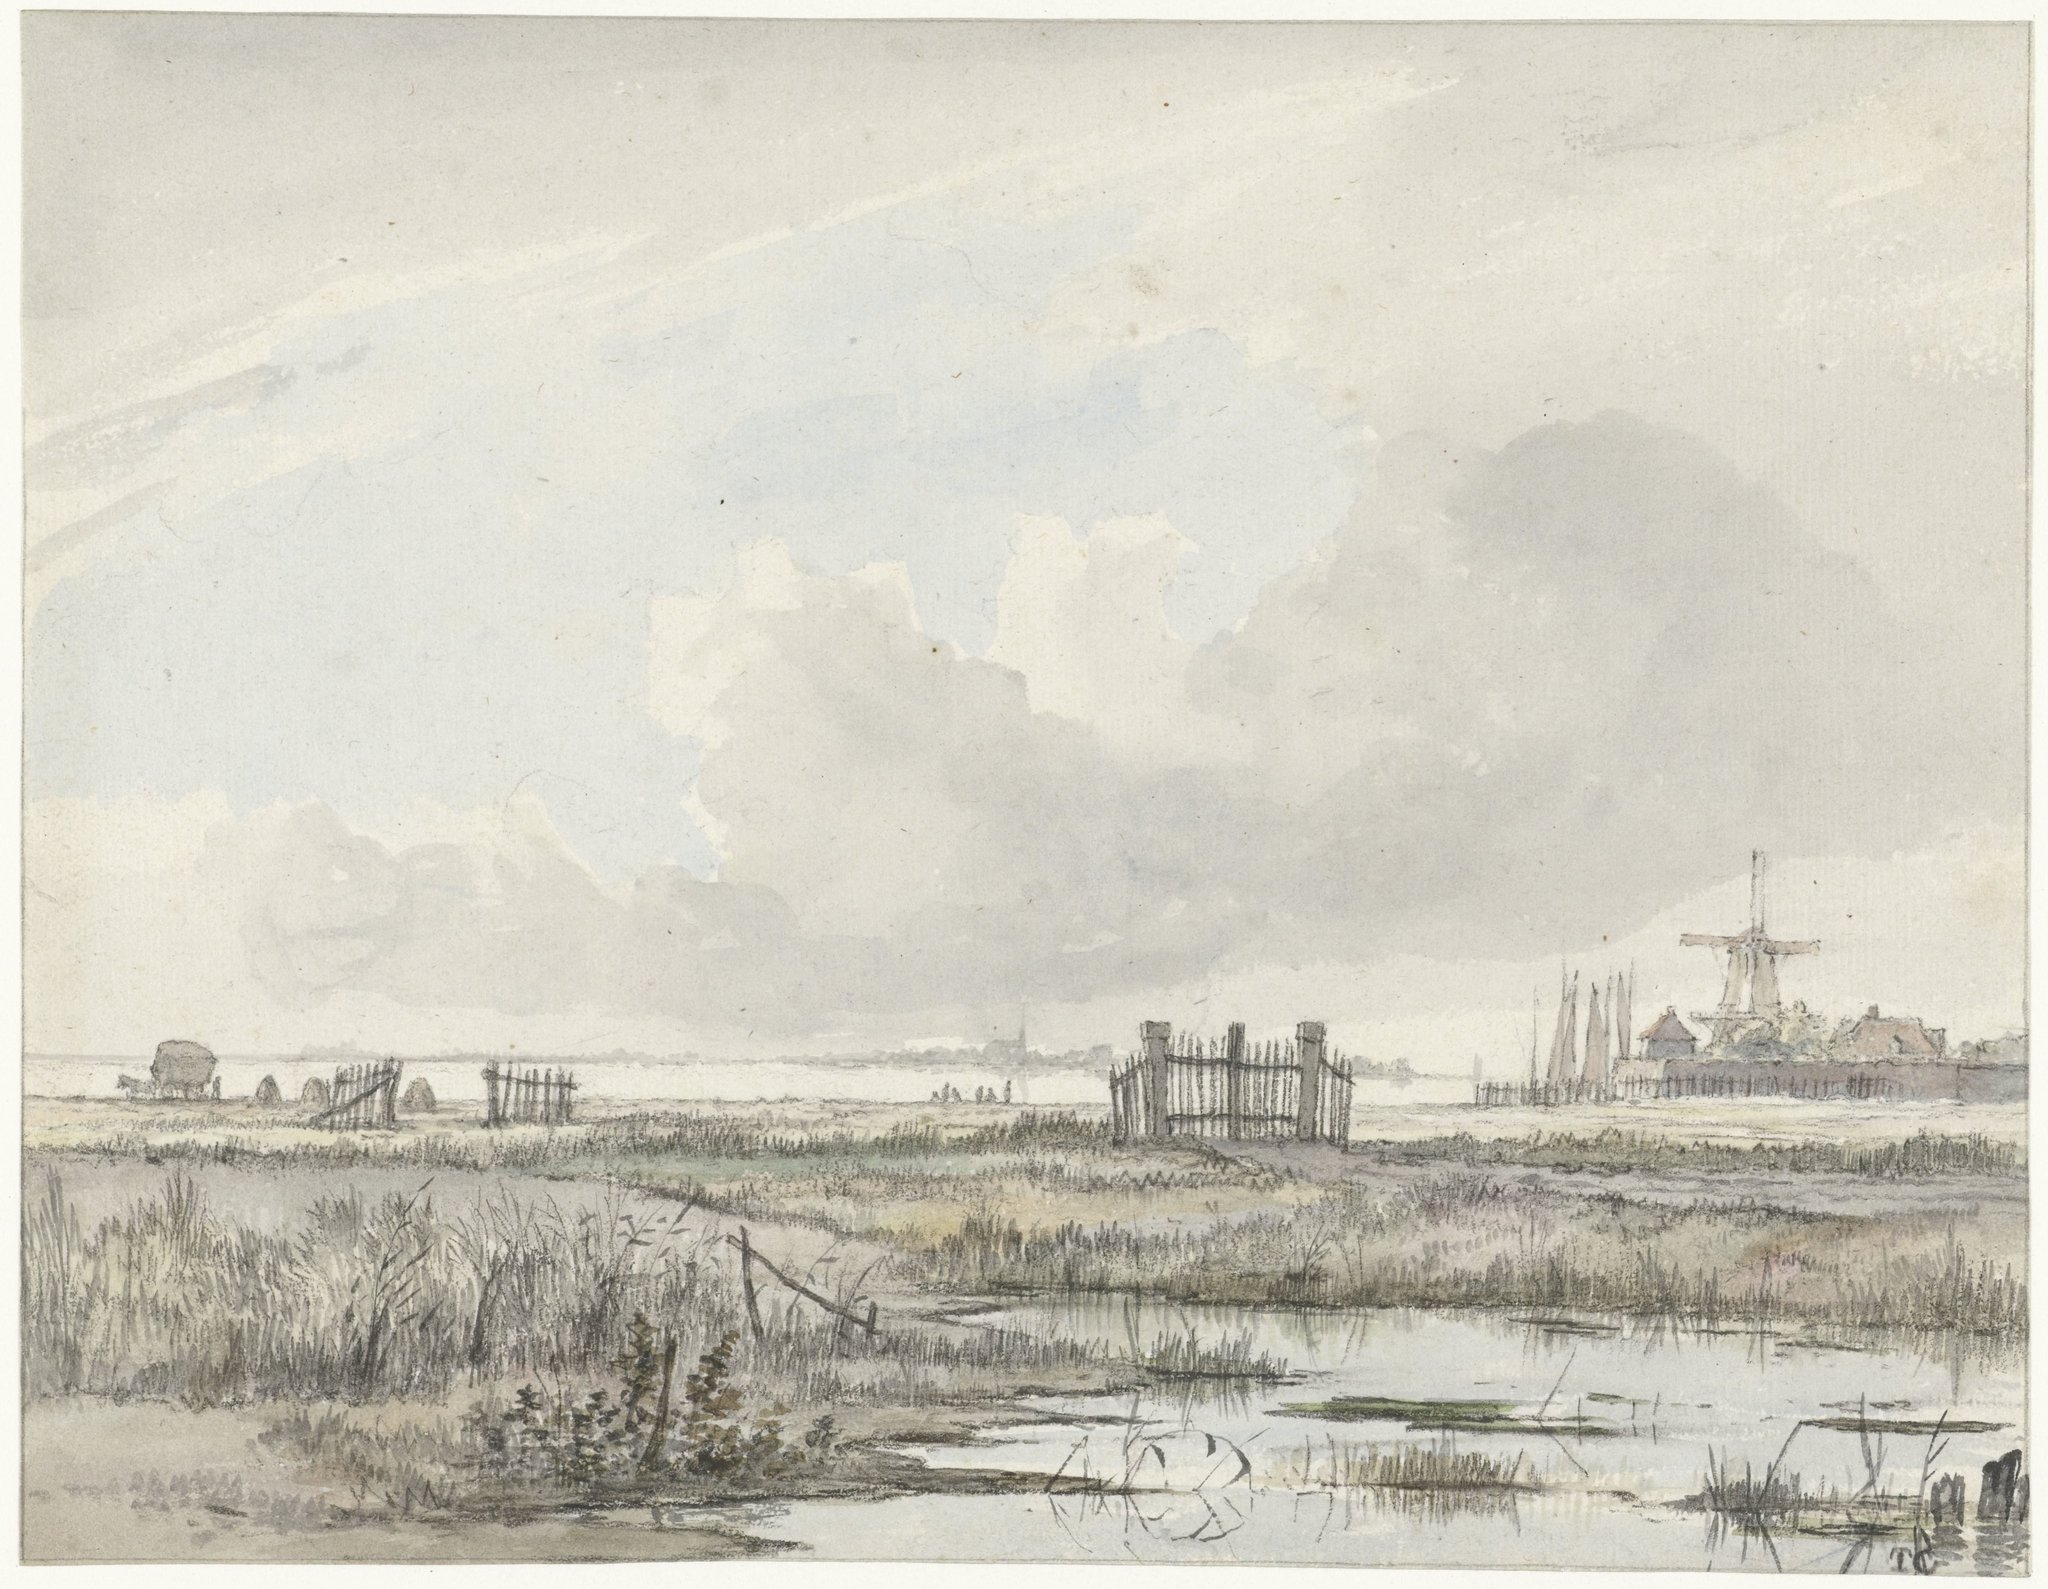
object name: drawing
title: Moerassig landschap buiten een stad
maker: hendrik gerrit ten cate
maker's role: draughtsman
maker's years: 1803-1856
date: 1836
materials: chalk, paper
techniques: brush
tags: swamp, inland marsh, fens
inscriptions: date: ‘1836’, signature, monogram